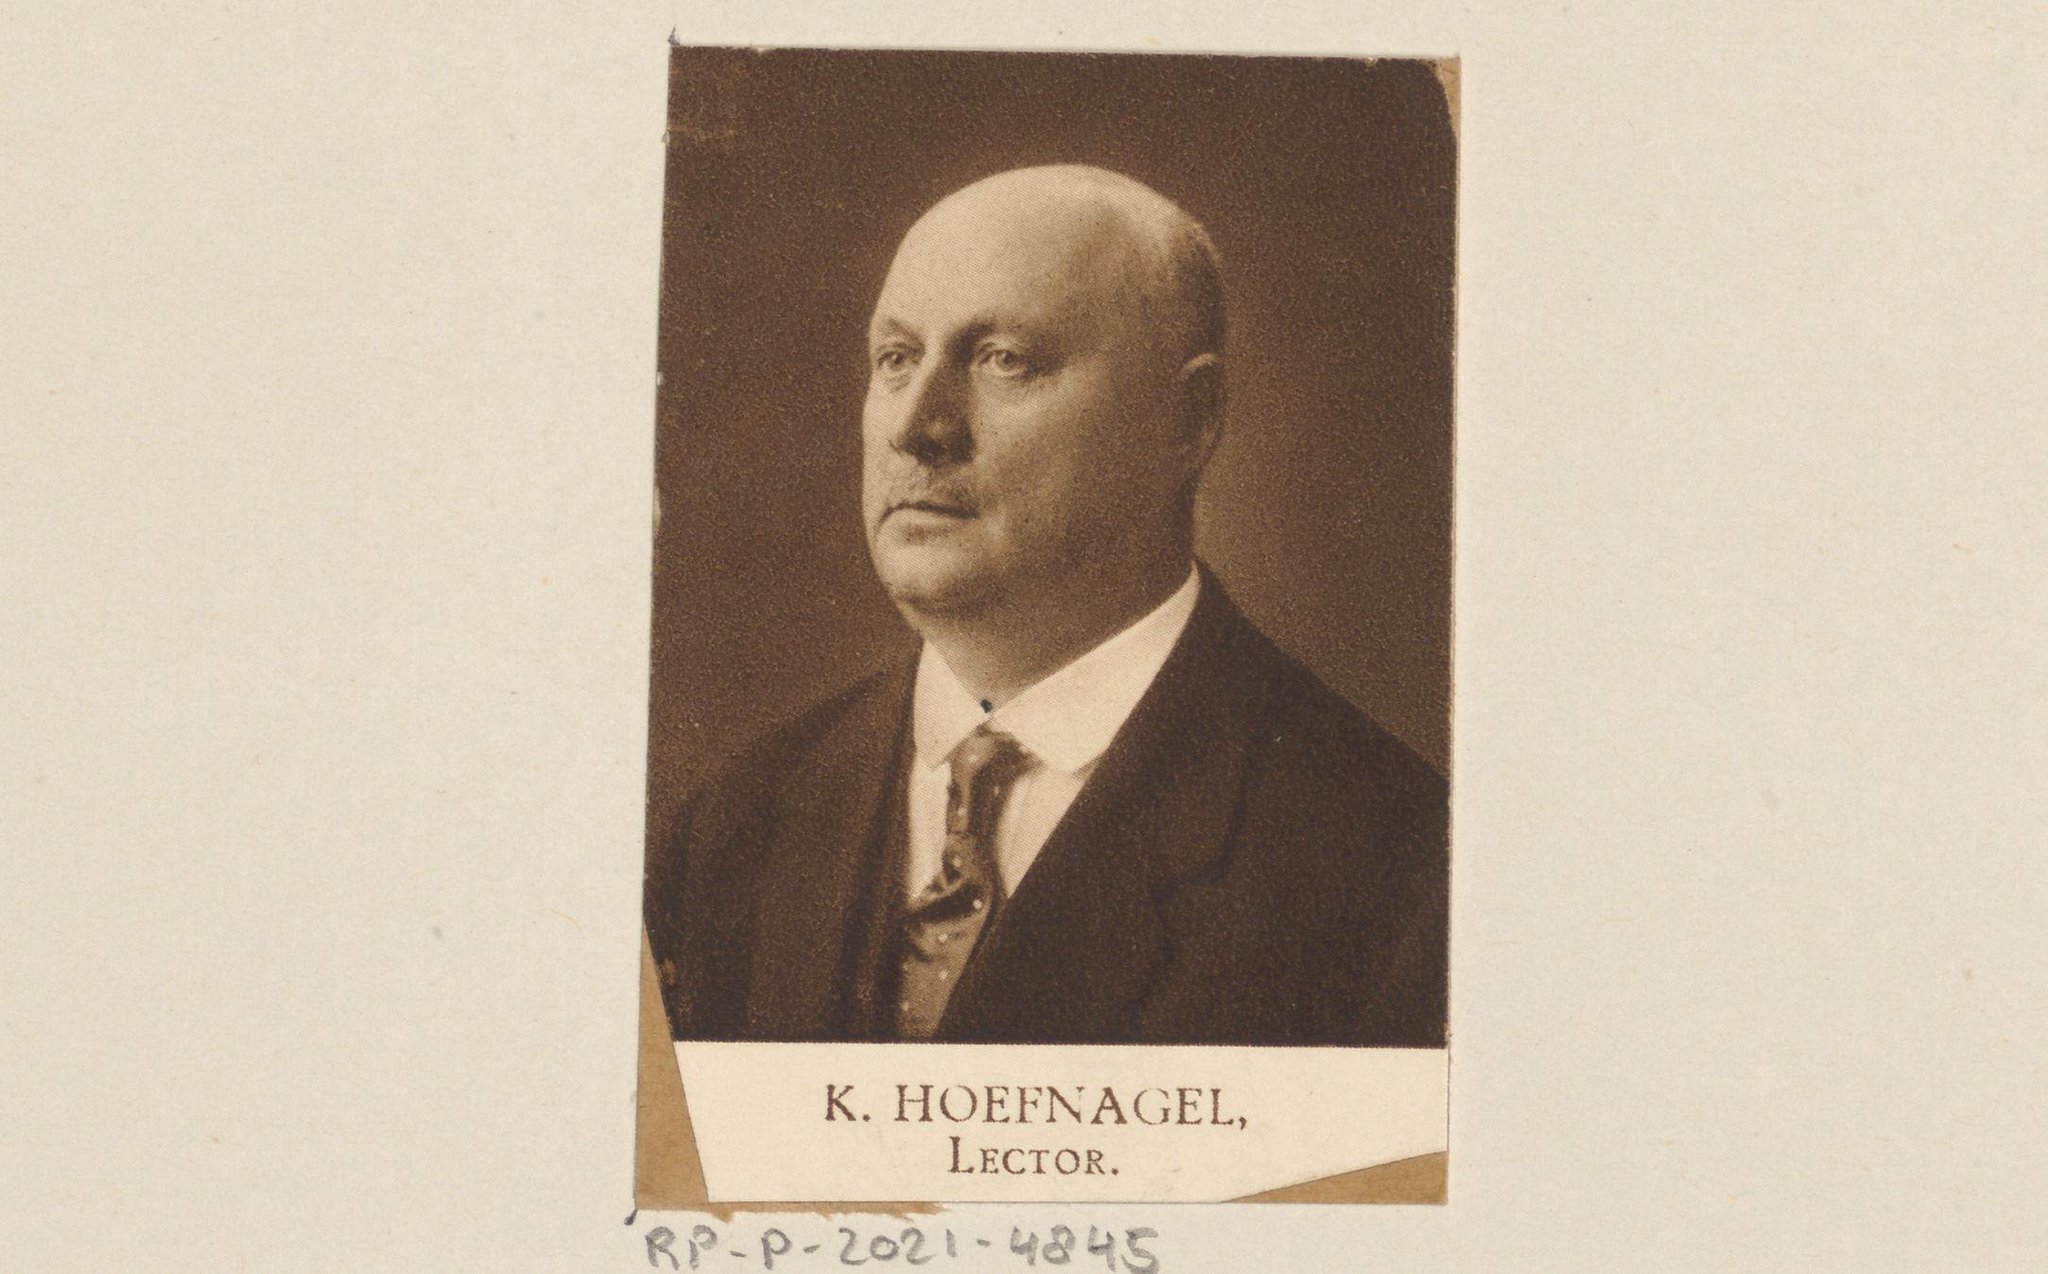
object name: photomechanical print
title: Portret van K. Hoefnagel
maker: Anonymous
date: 1895-1950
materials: paper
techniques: rotogravure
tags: historical persons